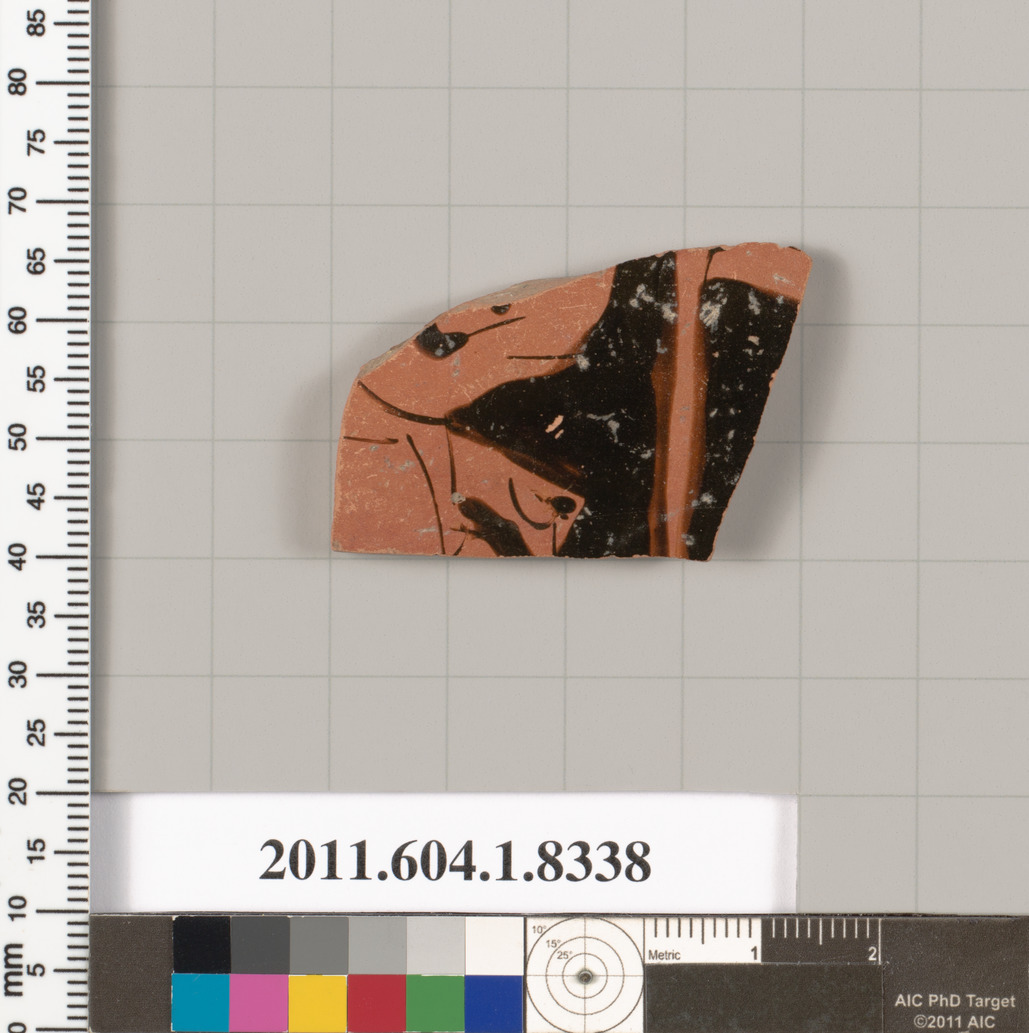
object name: kylix fragment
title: Terracotta fragment of a kylix (drinking cup)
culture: greek, attic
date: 400-351 BCE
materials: terracotta